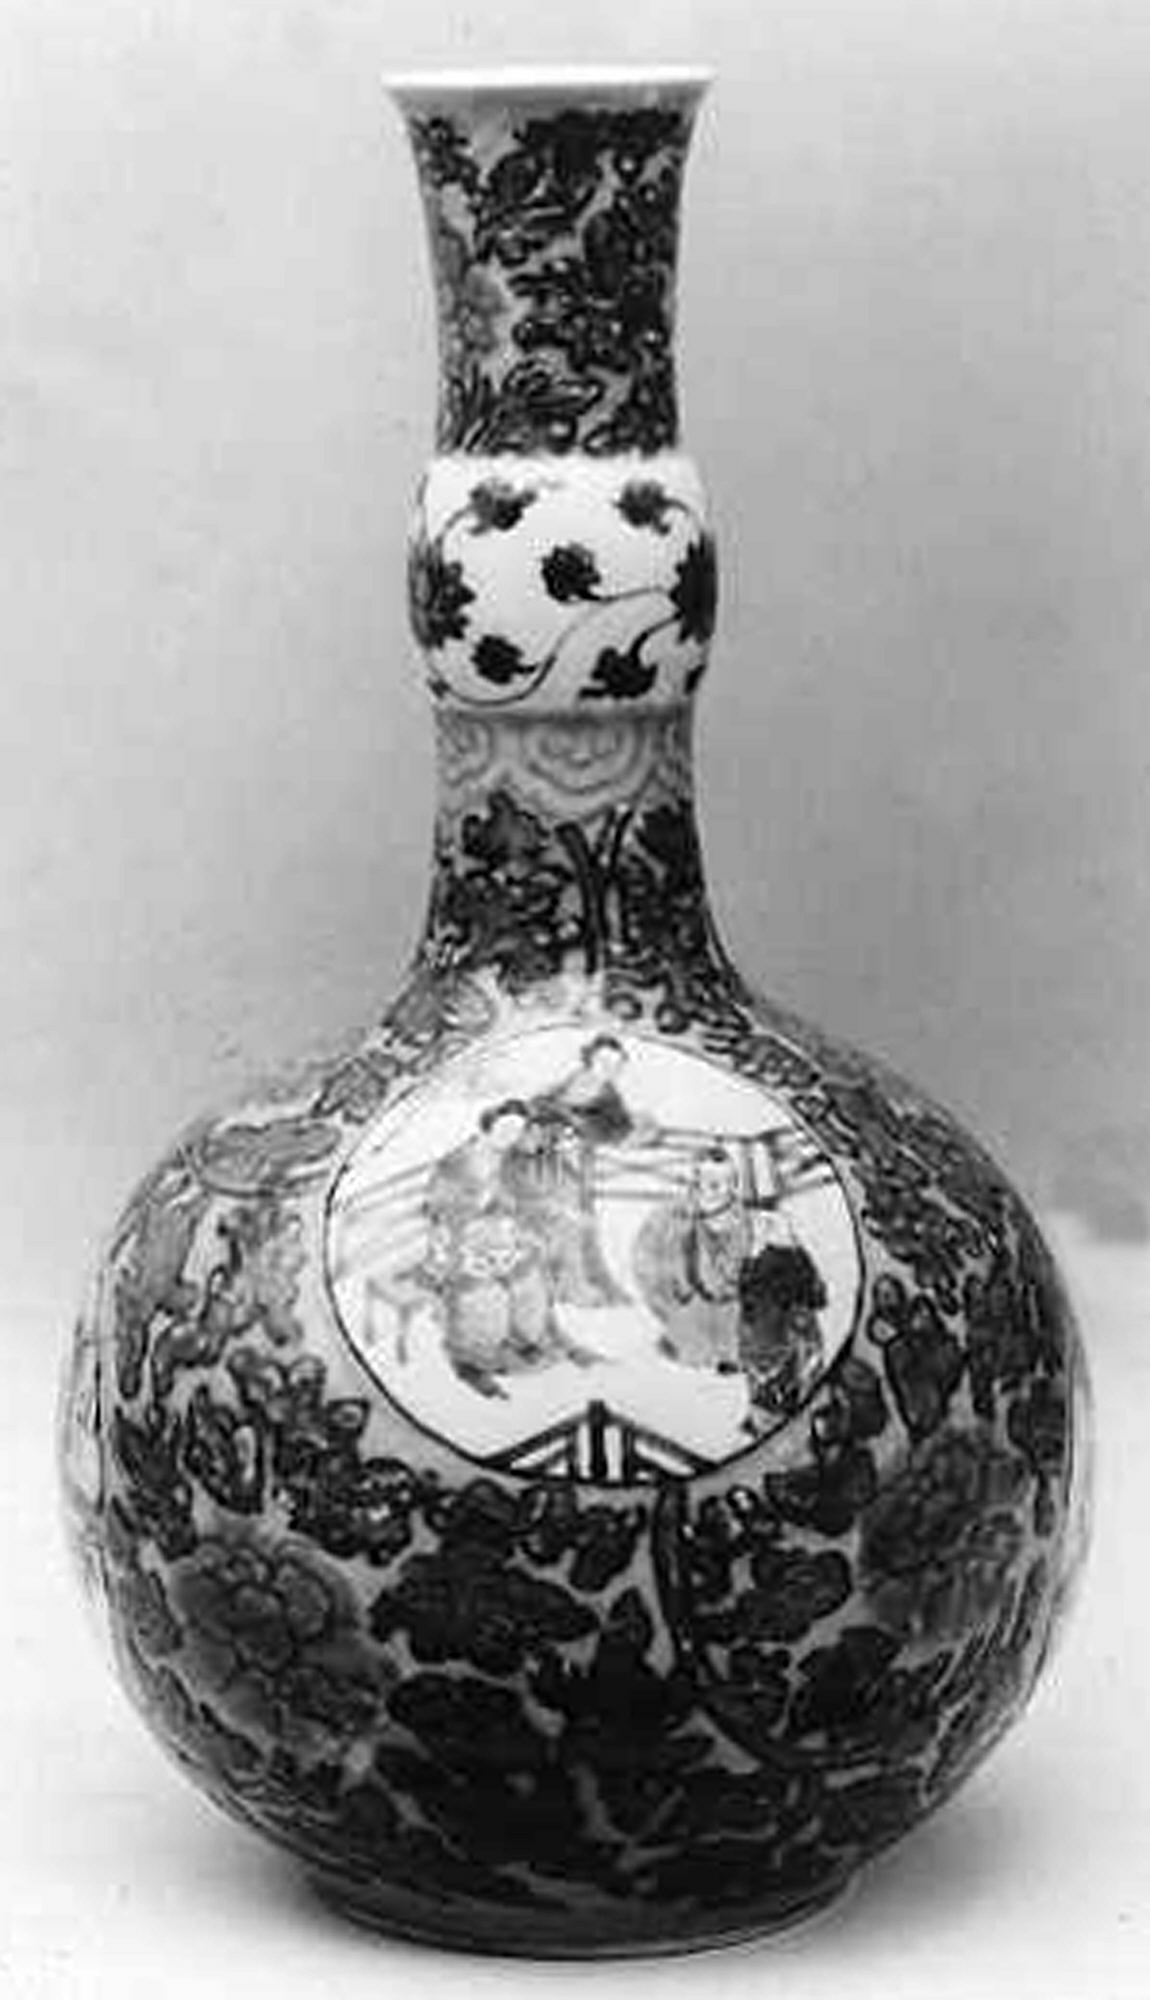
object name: bottle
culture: chinese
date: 1601-1700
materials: copper, porcelain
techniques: painting, underglaze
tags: human figures,flowers,leaves